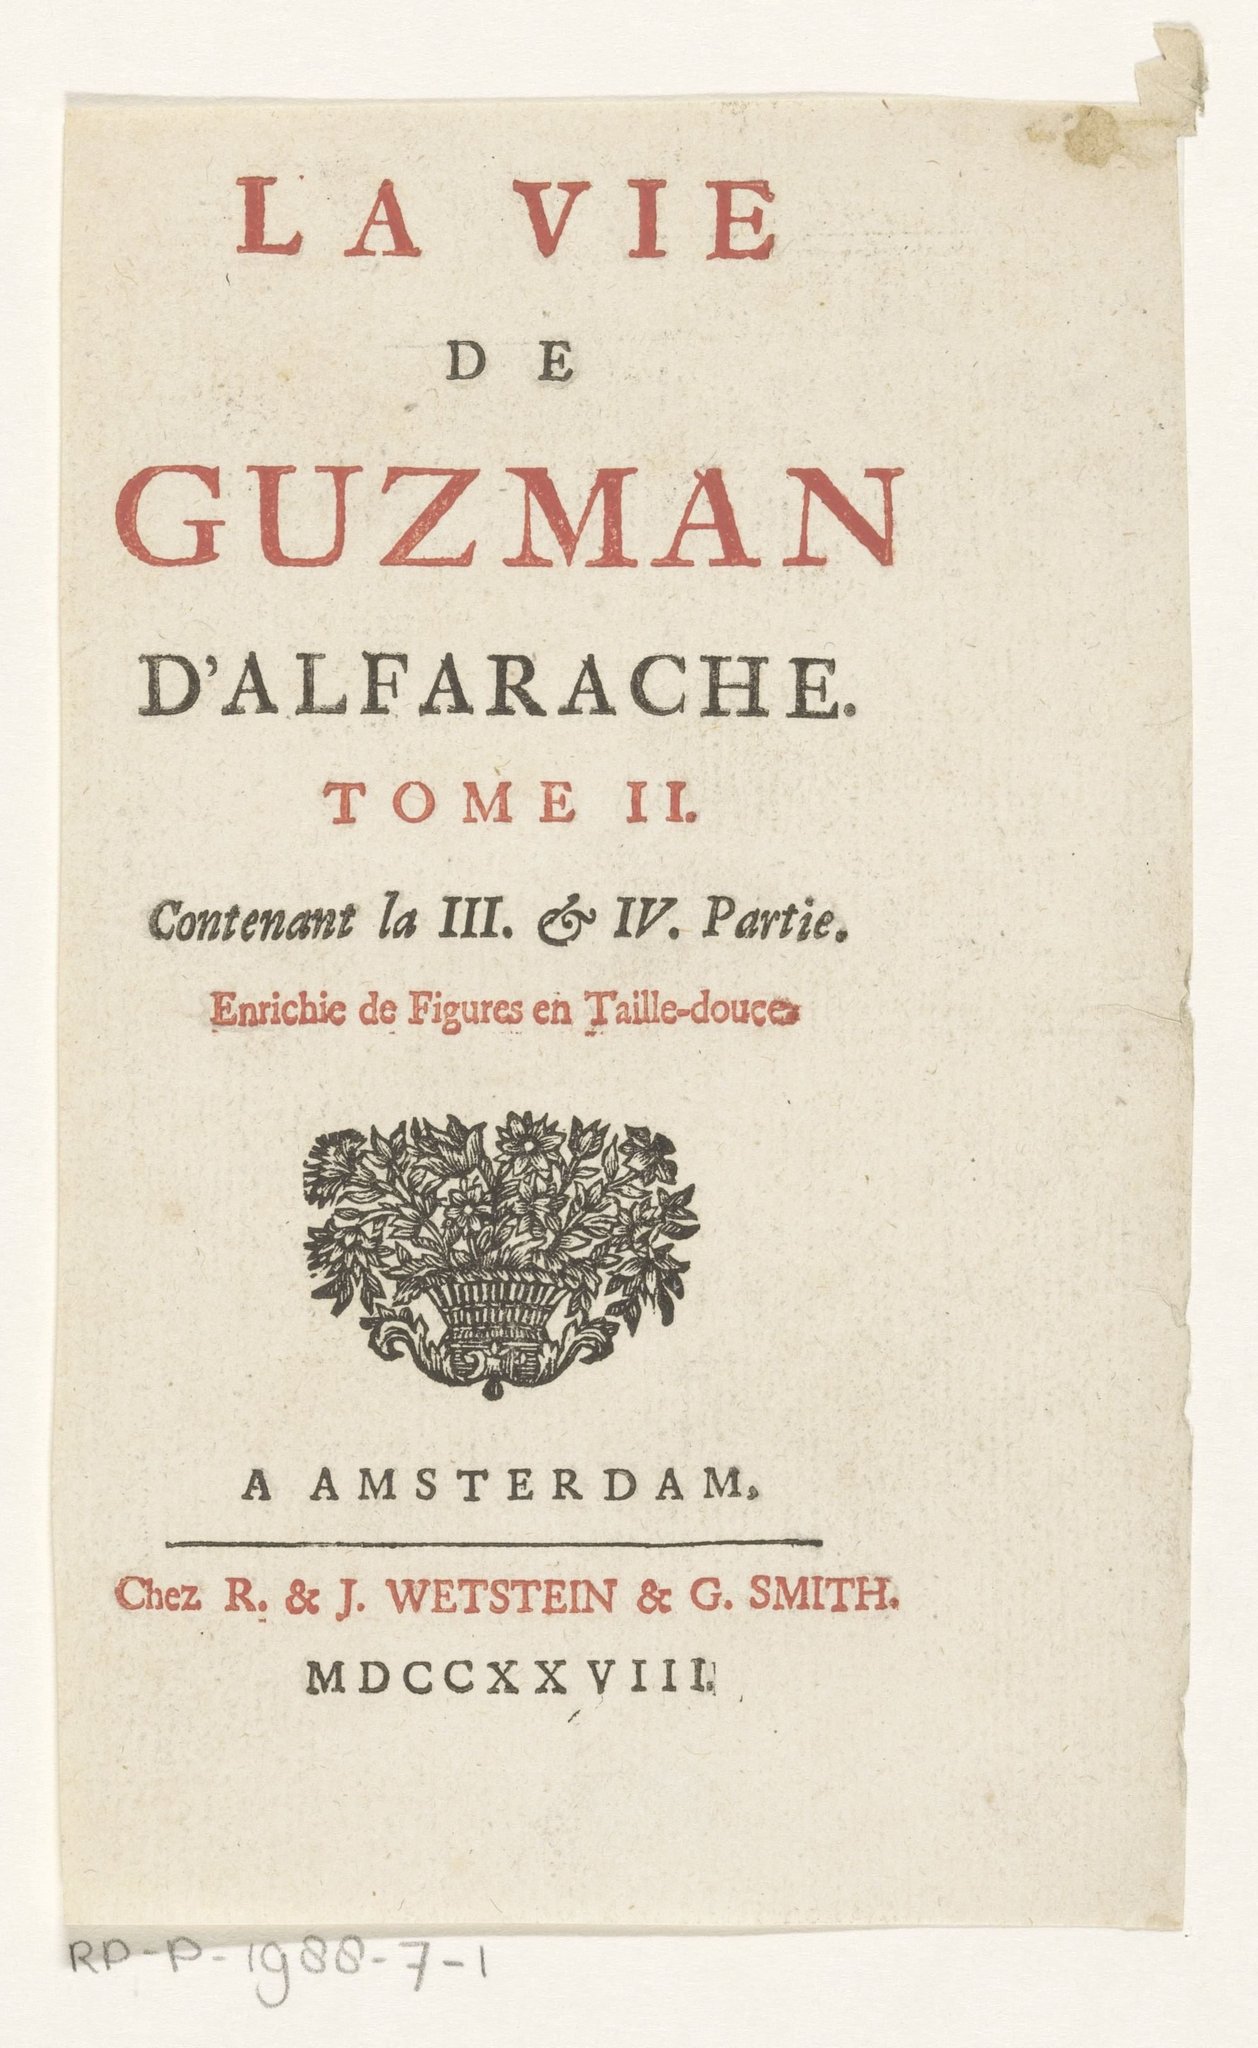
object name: print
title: Bloemenmand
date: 1728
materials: paper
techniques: letterpress printing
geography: amsterdam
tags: cut flowers; nosegay, bunch of flowers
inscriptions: collector's mark: Lugt 2760, collector's mark: Lugt 2228